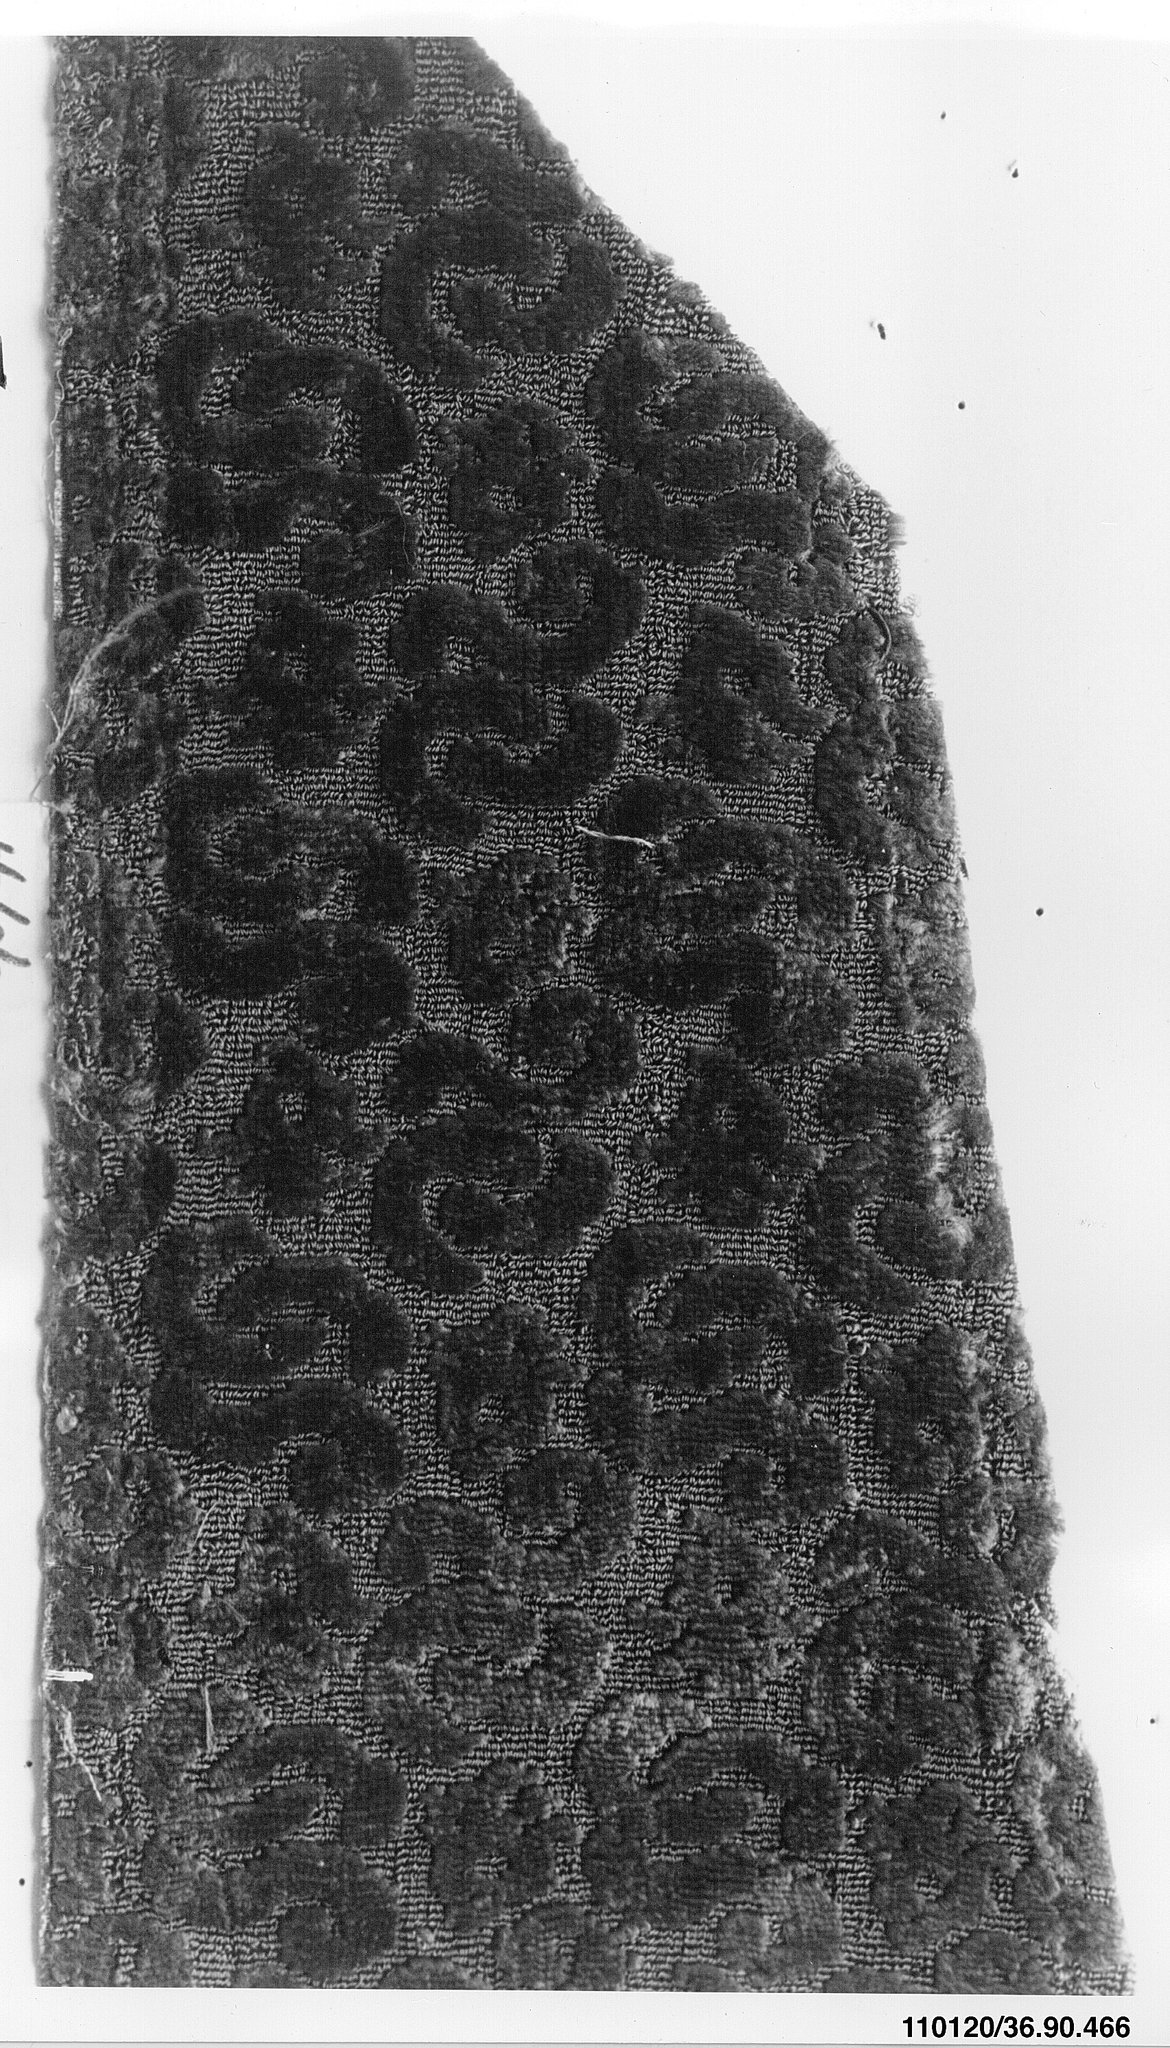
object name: piece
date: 1501-1700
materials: silk